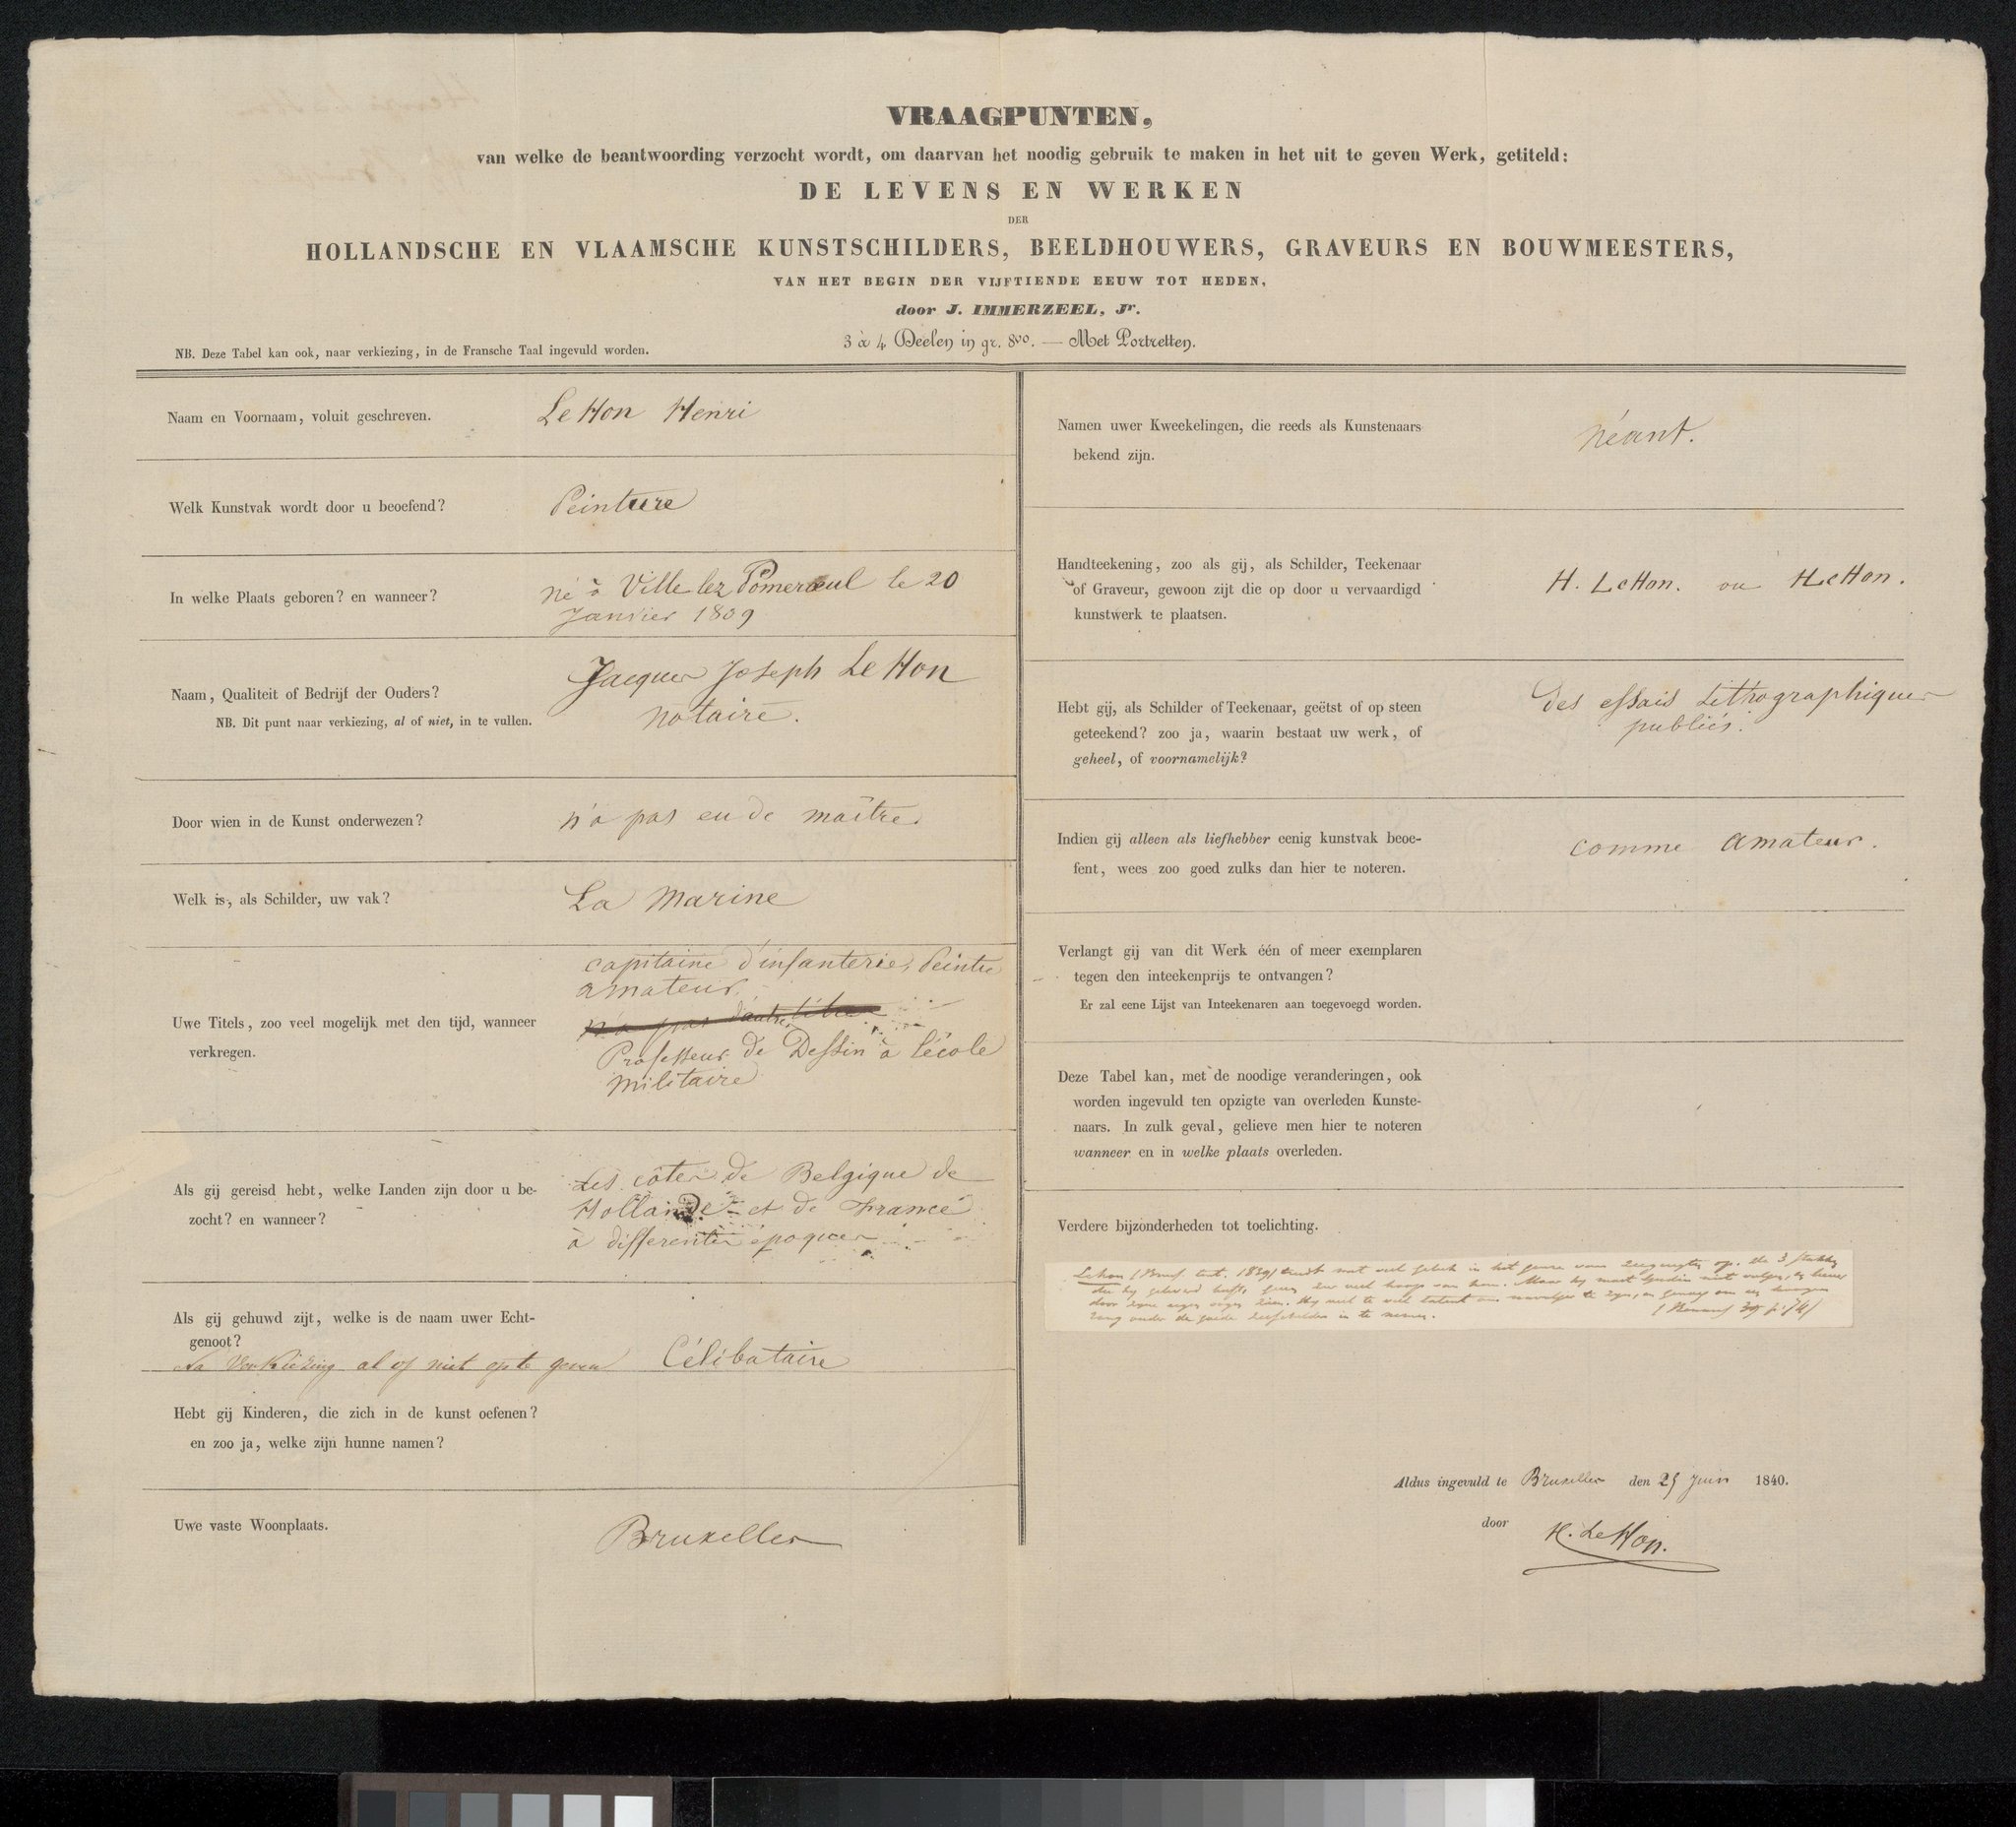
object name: manuscript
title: Enquêteformulier ingevuld door Henri Le Hon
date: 1840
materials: ink, paper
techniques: pen, printing, writing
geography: brussels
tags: print maker, draughtsman, henri le hon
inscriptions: watermark, inscription: ‘Vraagpunten,/ van welke de beantwoording verzocht wordt, om daarvan het noodig gebruik te maken in het uit te geven Werk, getiteld: De levens en werken/ der Hollandsche en Vlaamsche kunstschilders, beeldhouwers,/ graveurs en bouwmeesters, van het begin der vijftiende eeuw tot heden/ door J. Immerzeel, Jr.’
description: Opgenomen in: Immerzeel, J. Jr., De levens en werken der Hollandsche en Vlaamsche kunstschilders, beeldhouwers, graveurs en bouwmeesters, van het begin der vijftiende eeuw tot heden, Amsterdam: J.C. van Kesteren, 1842-1843.